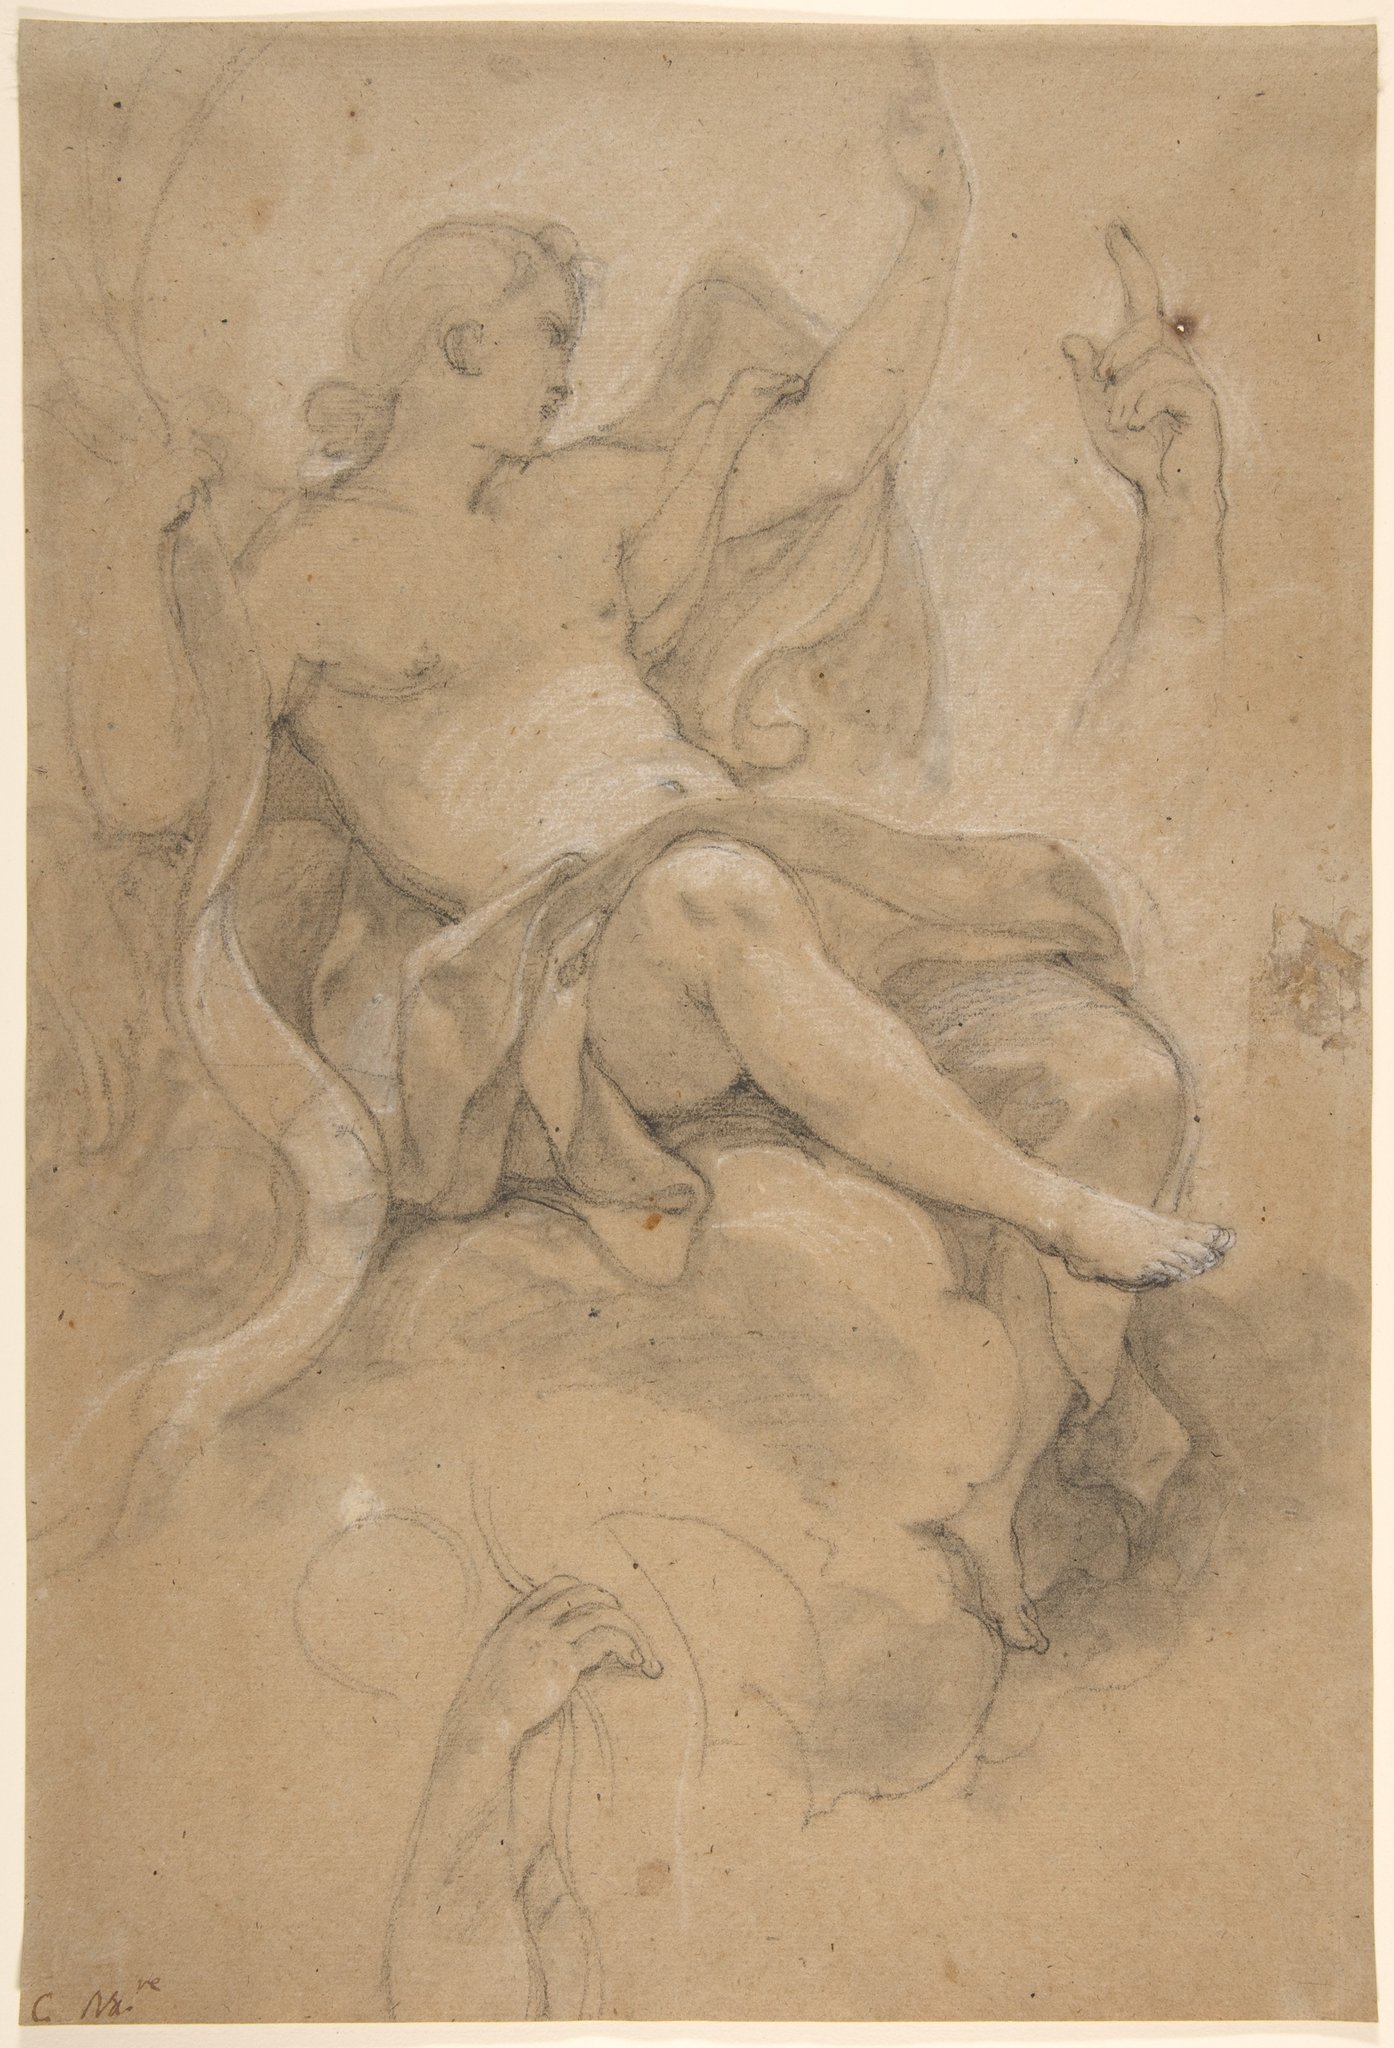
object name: drawing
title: Angel Holding a Banderole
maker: charles joseph natoire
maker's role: artist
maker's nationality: french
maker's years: 1700-1777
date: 1700-1777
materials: chalk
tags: angels